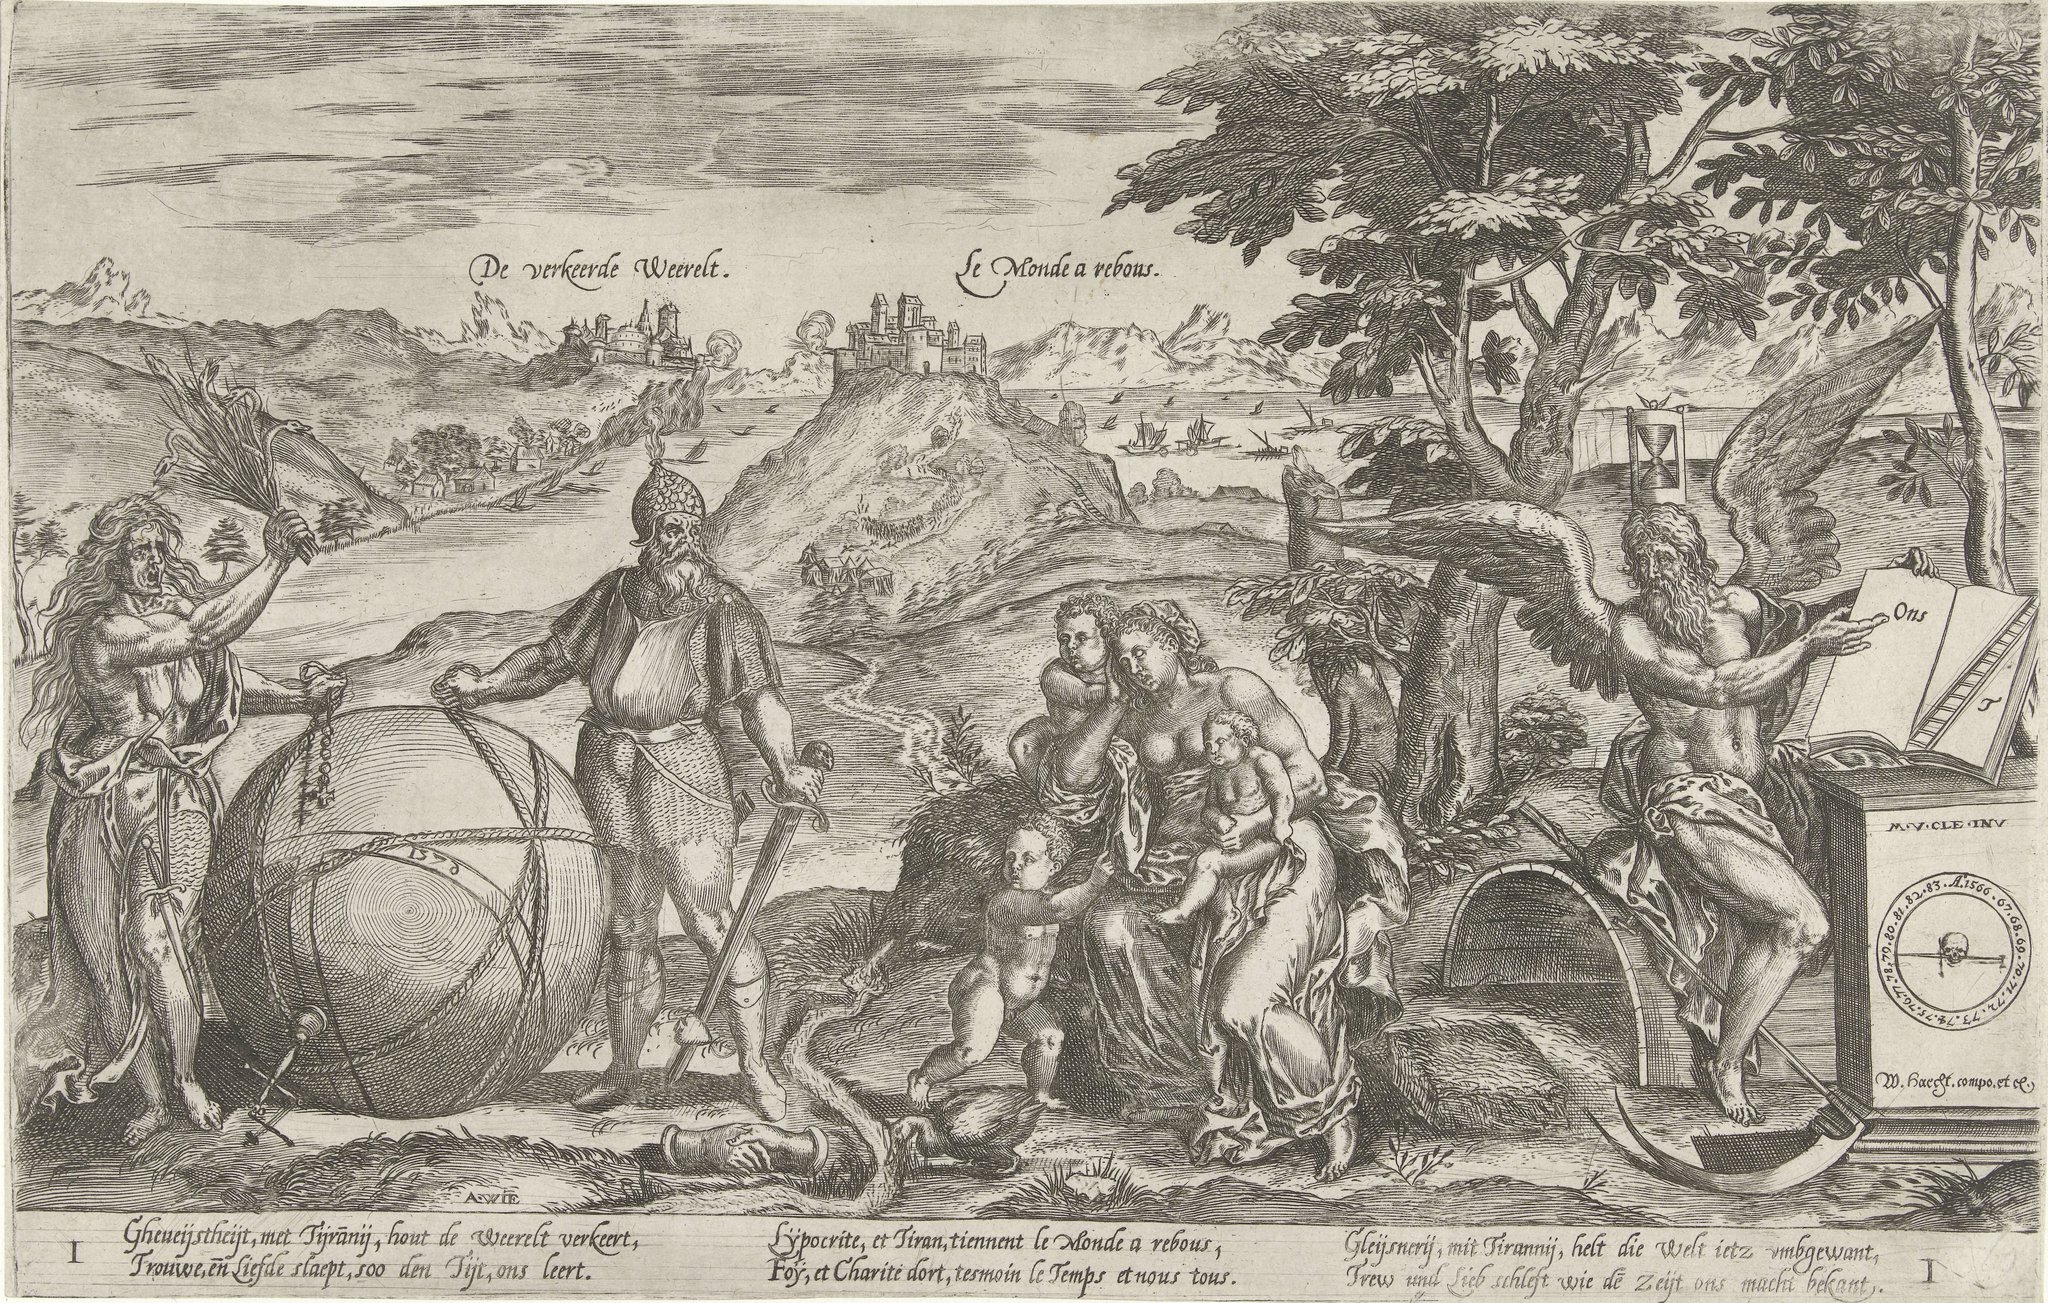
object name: propagandaprent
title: De verkeerde Weerelt / Le Monde a rebous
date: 1579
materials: paper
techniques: engraving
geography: southern netherlands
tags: charity, 'caritas'; 'carità' (ripa) ~ one of the three theological virtues, 'mundus inversus', the reversed world, the topsy-turvy world, 'le monde bestourné', father time, man with wings and scythe, dissimulation, hypocrisy; 'hippocresia', 'simulatione' (ripa), dictatorial government, tyranny; 'tirannide' (ripa)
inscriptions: signature: ‘M.V.CLE.INV’, signature: ‘W.Haecht.compo.et ex.’, number: ‘I’, inscription: ‘De verkeerde Weerelt. / Le Monde a rebous.’, signature: ‘A.WIE’, caption: ‘Gheueijstheijt, met Tijranij...ons macht bekant.’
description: Landschap waarin allegorische figuren en beeldelementen samen een rebus vormen. Personificaties van Geveinsdheid en Tirannie houden links de wereld ondersteboven, daarnaast de slapende Liefde en Tijd met een opengeslagen boek. In het onderschrift de oplossing van de rebus in 3 verzen van elk 2 regels in het Nederlands, Frans en Duits. Genummerd rechts- en linksonder: I / I.